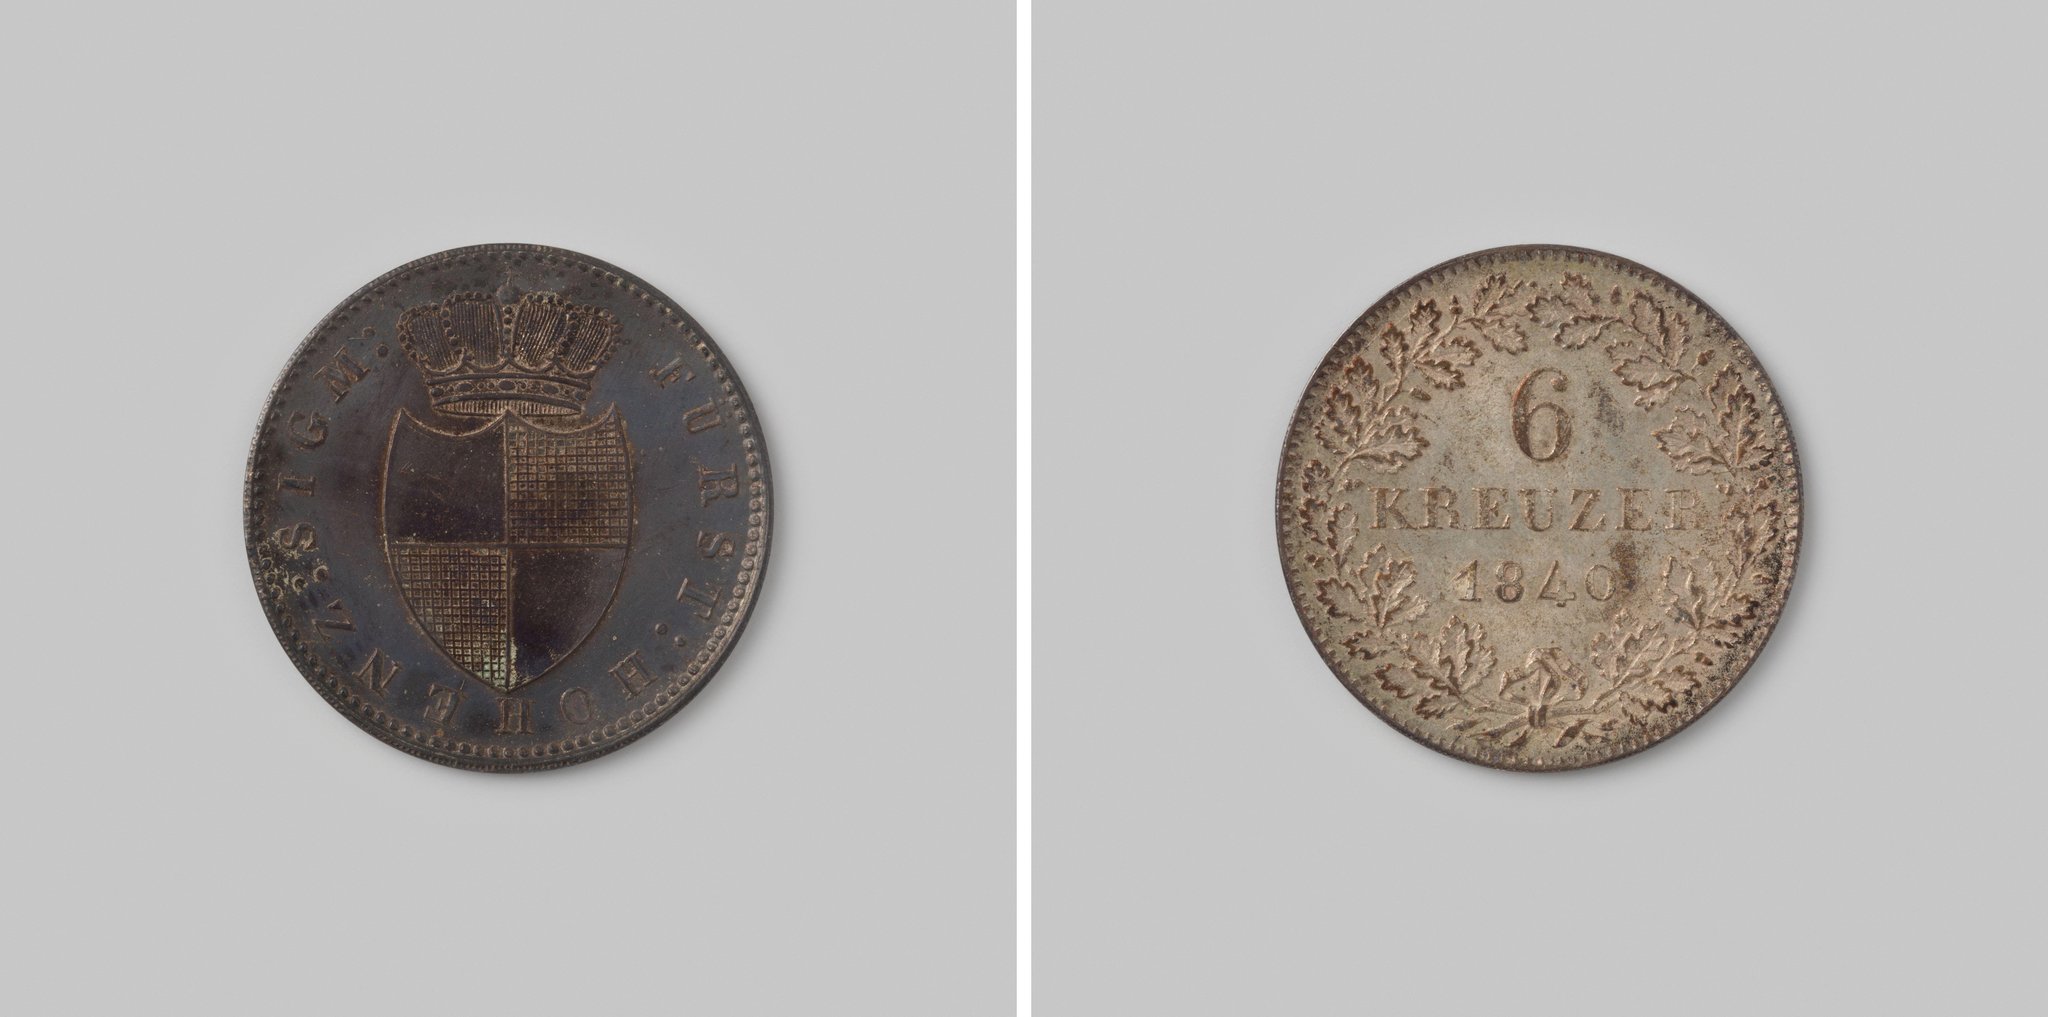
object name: coin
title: 6 Kreuzer uit Hohenzollern-Sigmaringen van Karel III, 1840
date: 1840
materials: silver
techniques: striking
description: Zilveren munt. Voorzijde: gekroond wapenschild. Keerzijde: binnen een krans van eikebladeren waarde-aanduiding in twee regels, waaronder jaartal. Kartelrand.